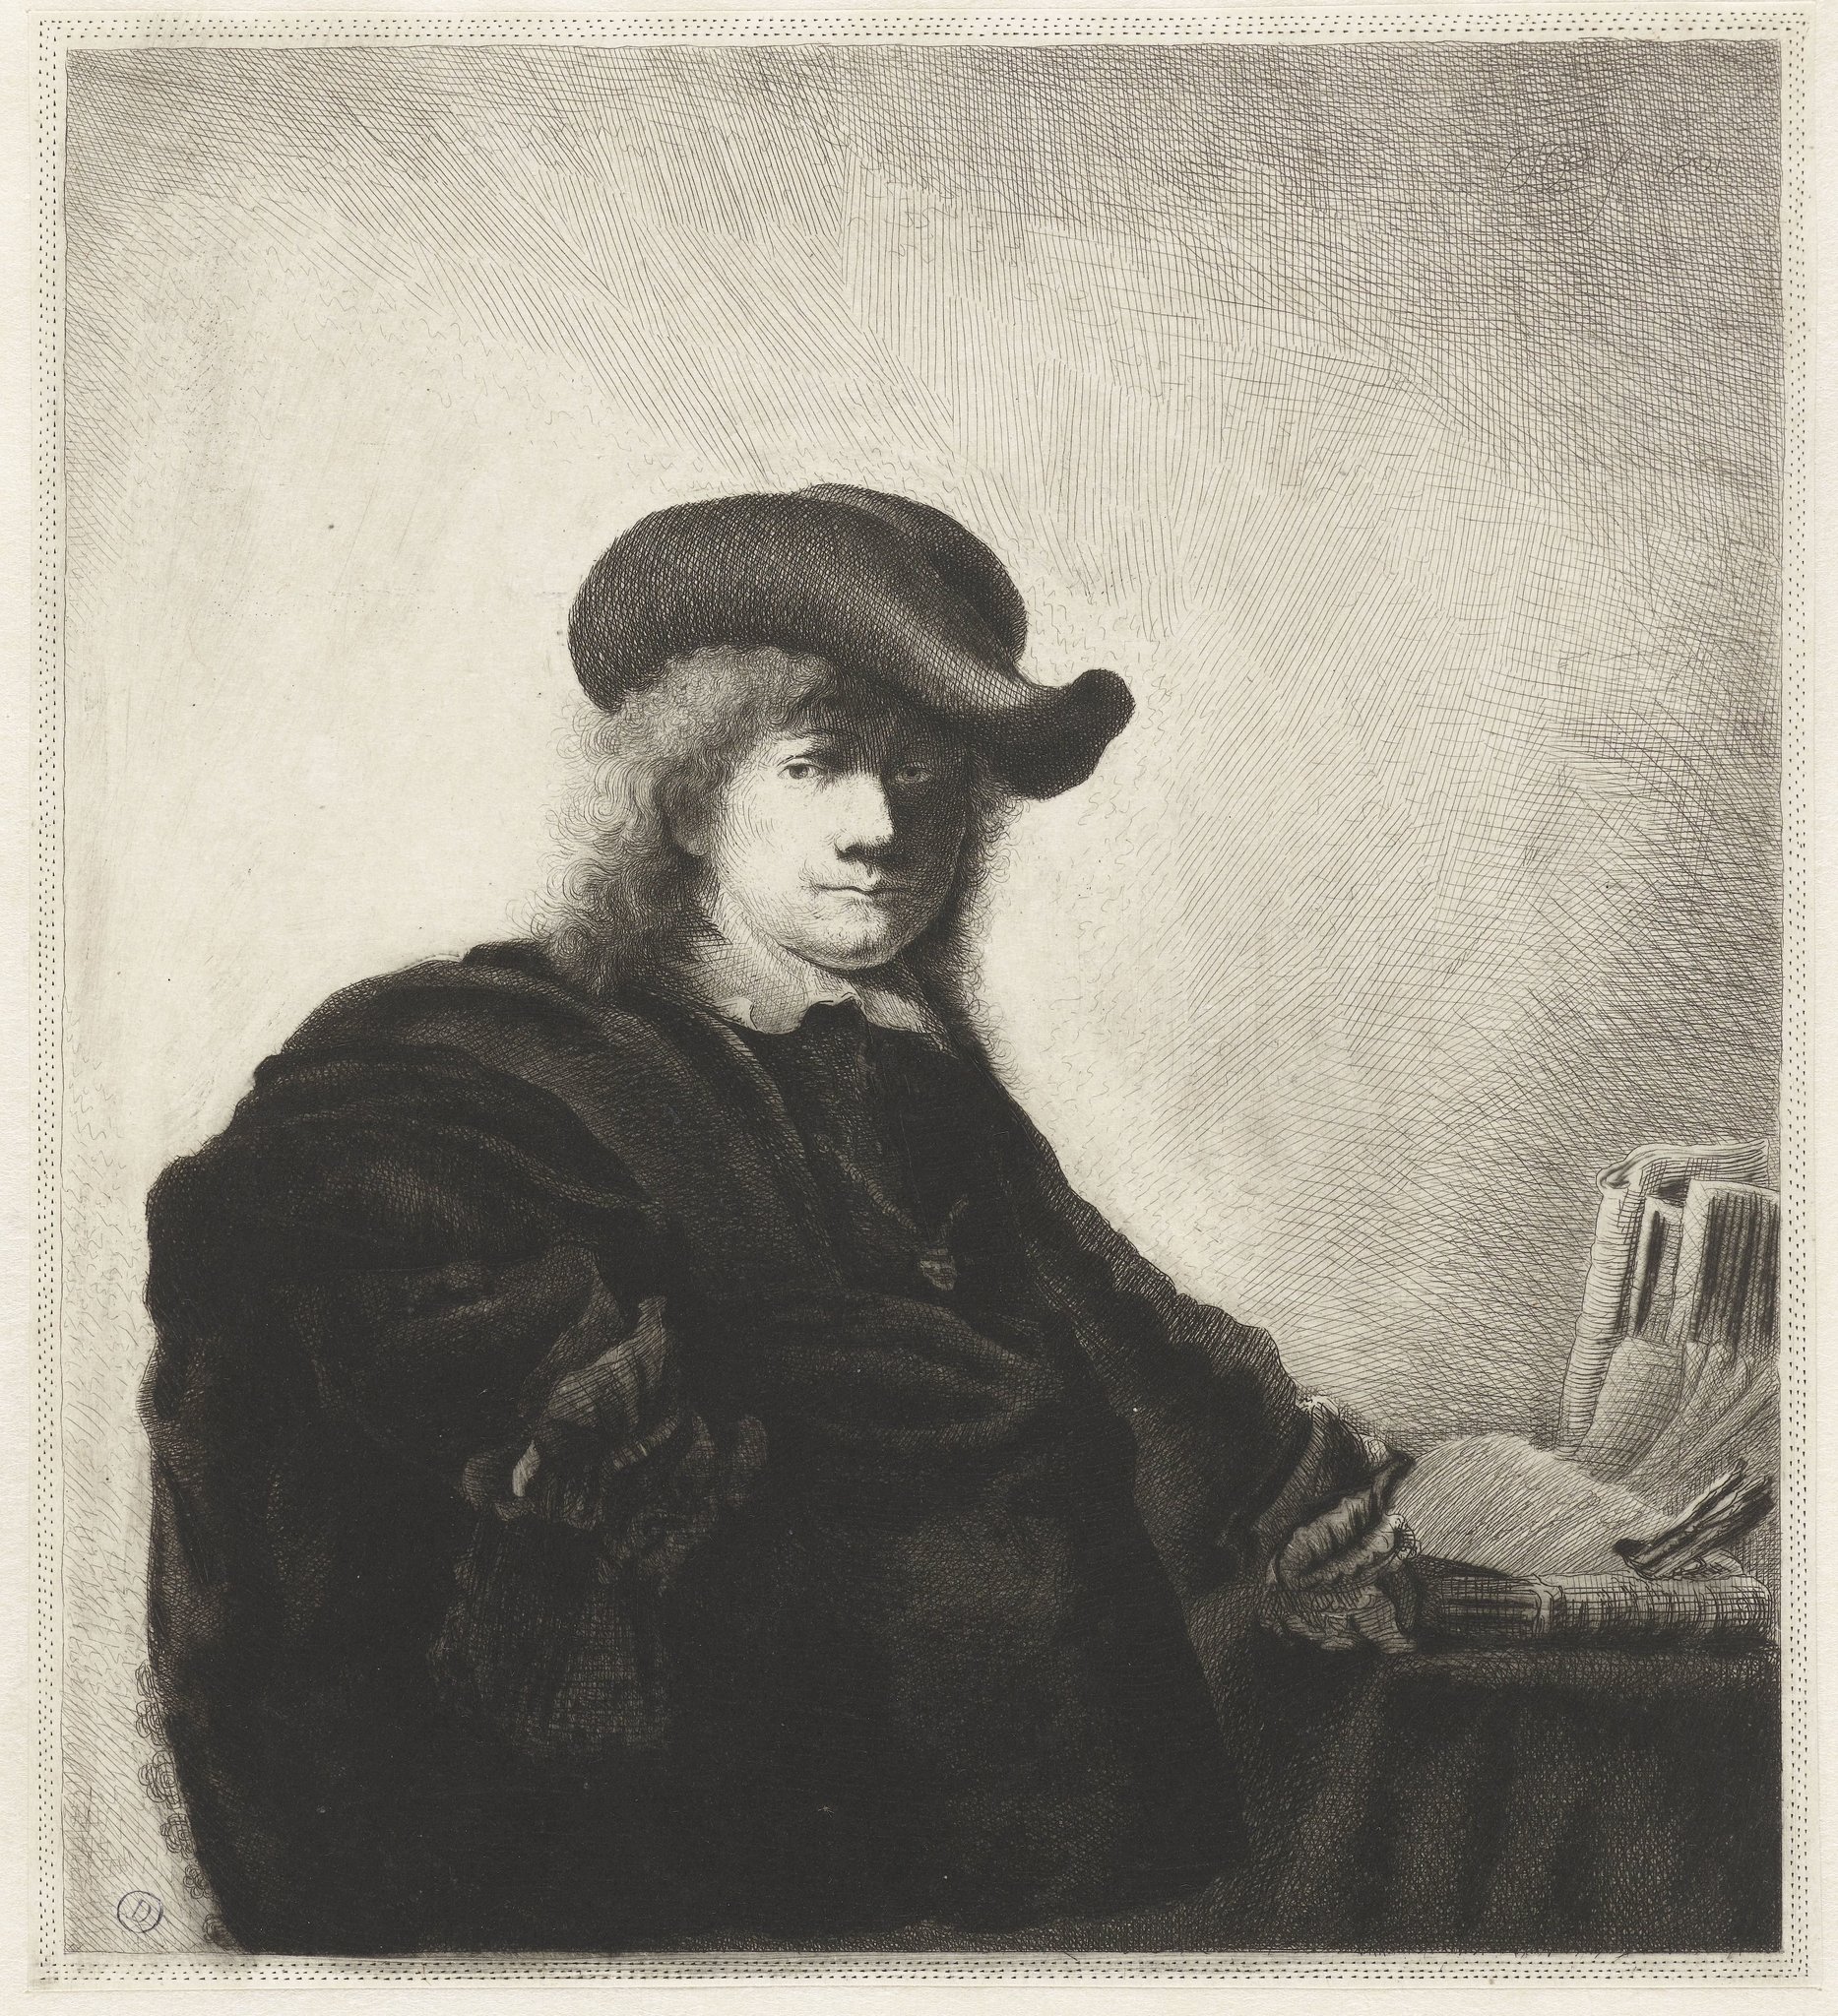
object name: print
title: Self-portrait in a soft hat and a patterned cloak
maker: ignace-joseph de claussin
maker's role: print maker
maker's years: 1766-1844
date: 1805-1844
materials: paper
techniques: etching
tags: amsterdam, painter, print maker, draughtsman, rembrandt van rijn, portrait, self-portrait of graphic artist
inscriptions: collector's mark: Lugt 2228, collector's mark: Lugt 2760, collector's mark: Lugt 1138c, collector's mark: Lugt 711a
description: Spiegelbeeldige kopie naar de gelijknamige prent van Rembrandt. Het lichaam overgenomen van het portret van Jan Asselijn door Rembrandt (NHD 239).